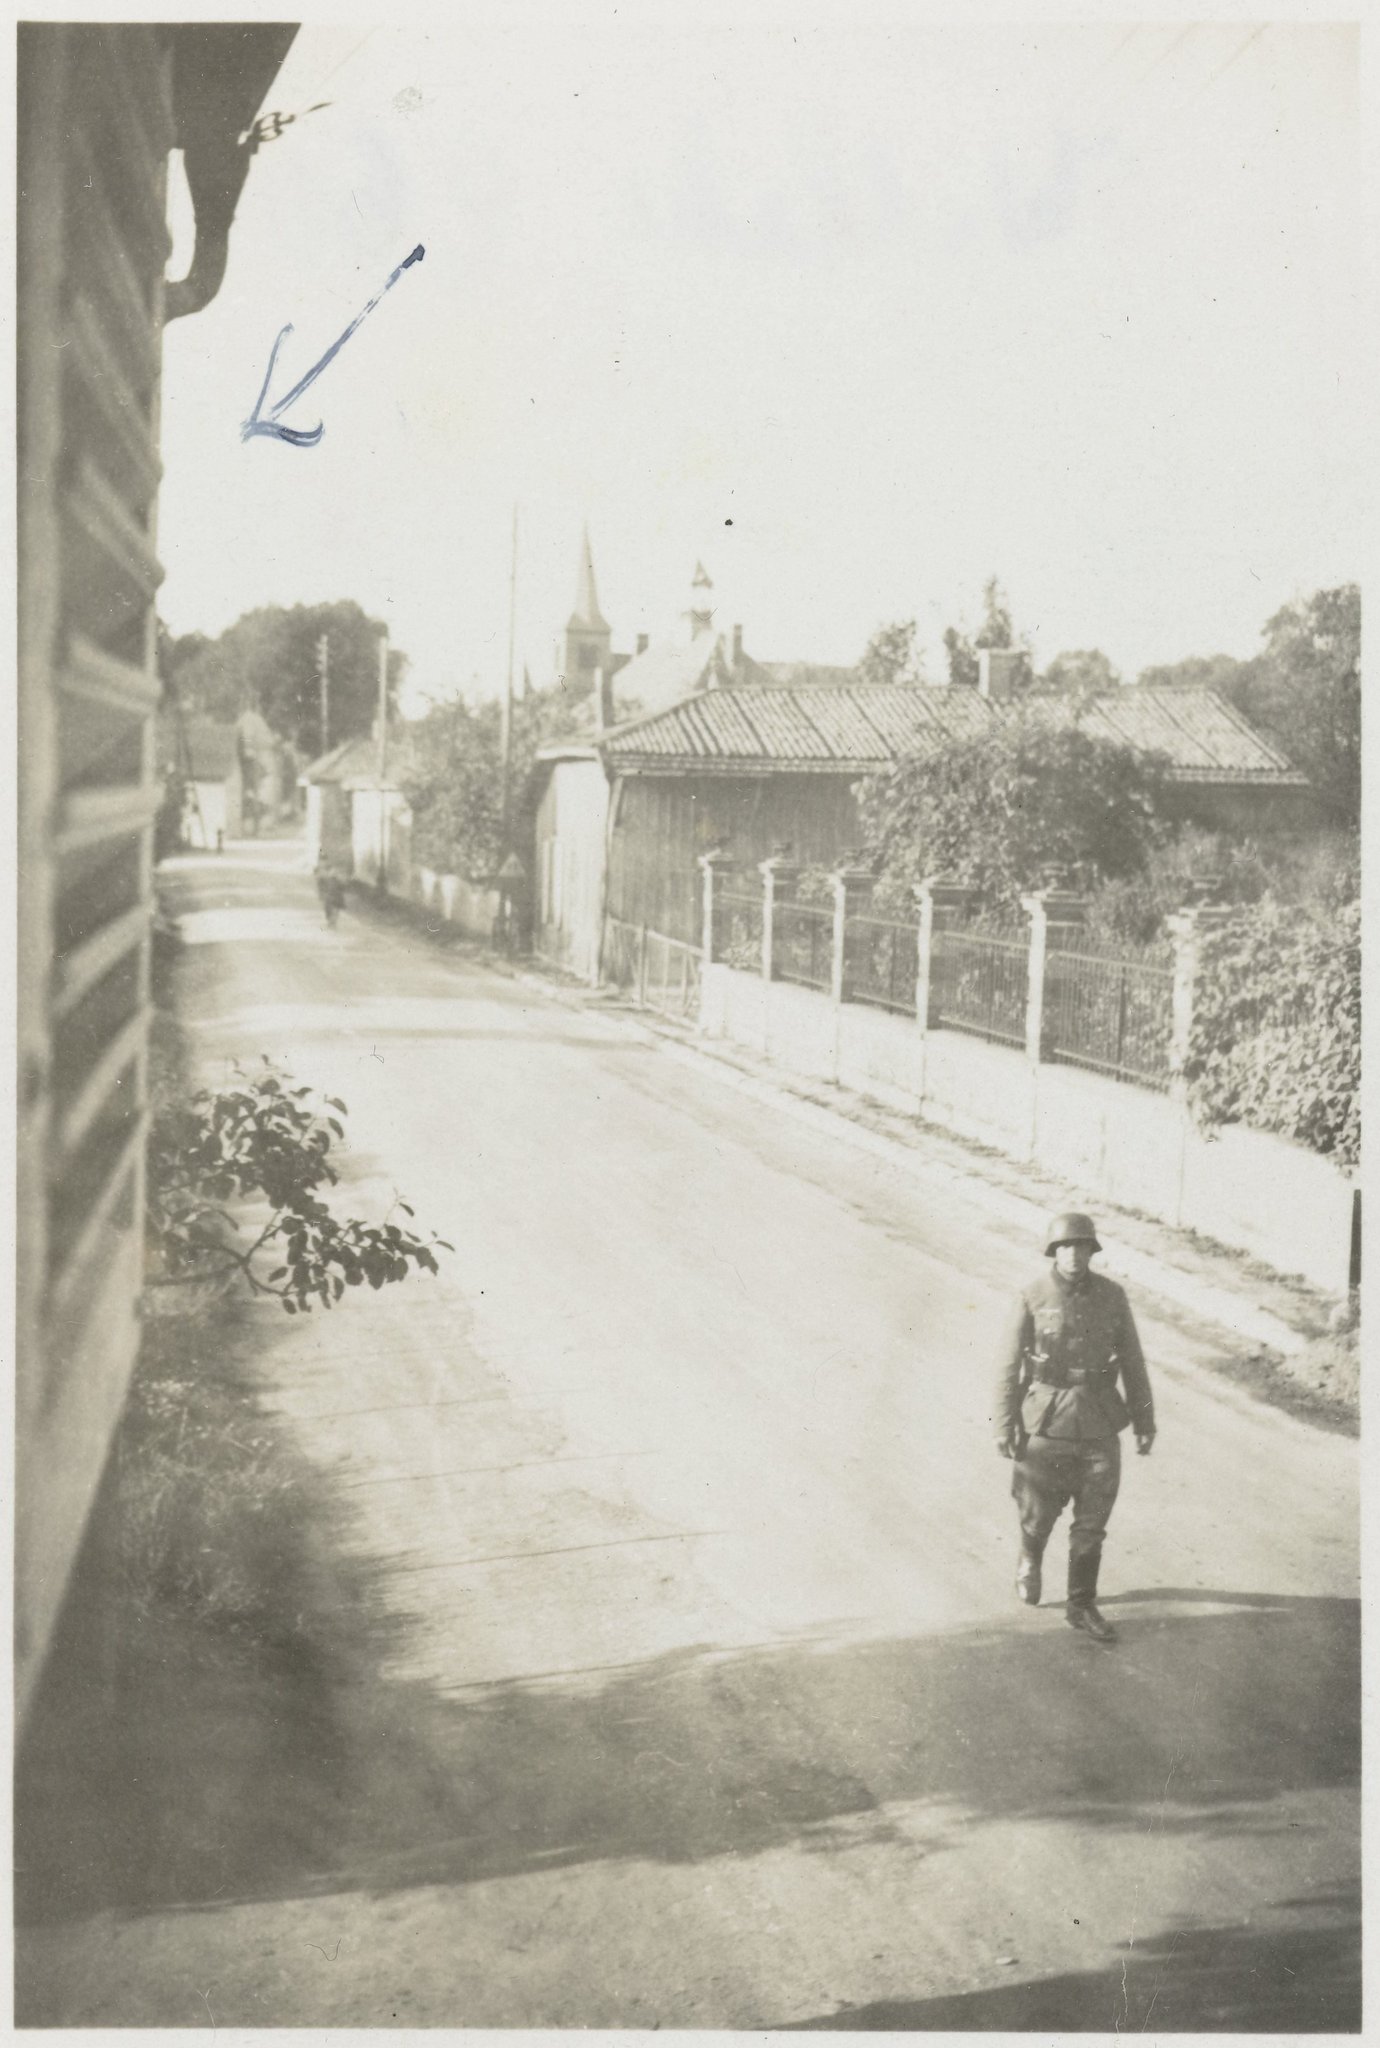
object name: photograph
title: Soldaat loopt over straat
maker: Anonymous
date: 1940-1945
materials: photographic support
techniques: gelatin silver print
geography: germany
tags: netherlands, germany, france, belgium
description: Een soldaat loopt door een lege straat met aan weerszijden huizen. Foto behorend bij album 'Kriegserinnerungen'.